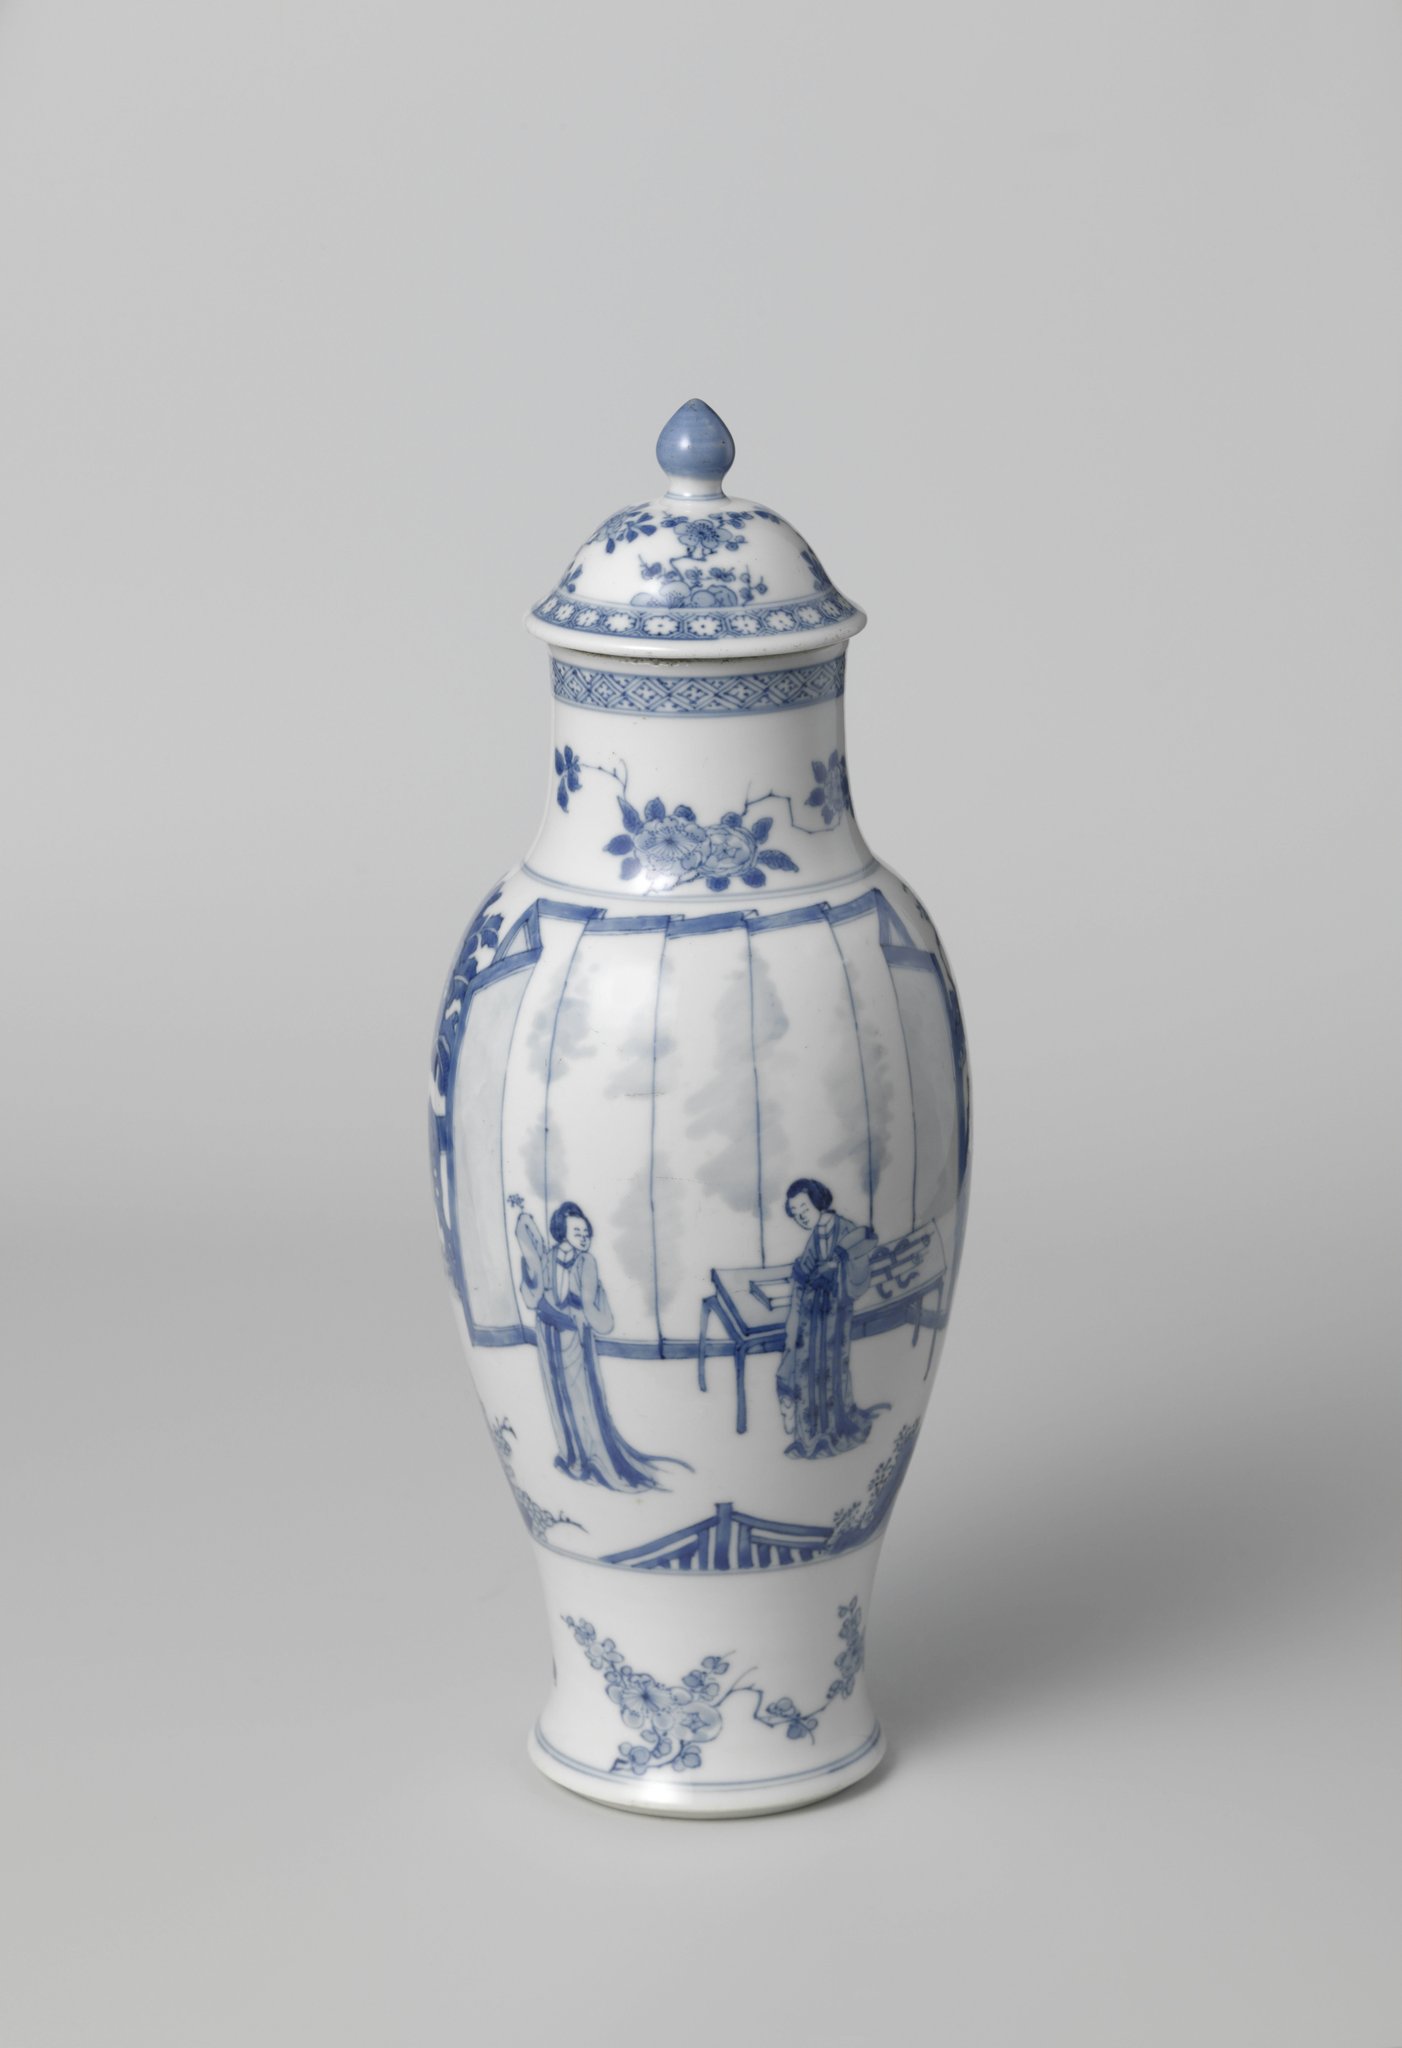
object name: lid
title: Baluster covered vase with women in a fenced garden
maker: Anonymous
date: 1700-1724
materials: cobalt, glaze, paint, porcelain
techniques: firing, turning, vitrification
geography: china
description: Deksel van dekselpot van porselein, beschilderd in onderglazuur blauw. Op de deksel vier bloemtakken met een band met geometrisch motief en een blauwe knop. Een chip in de rand van de deksel. Blauw-wit.